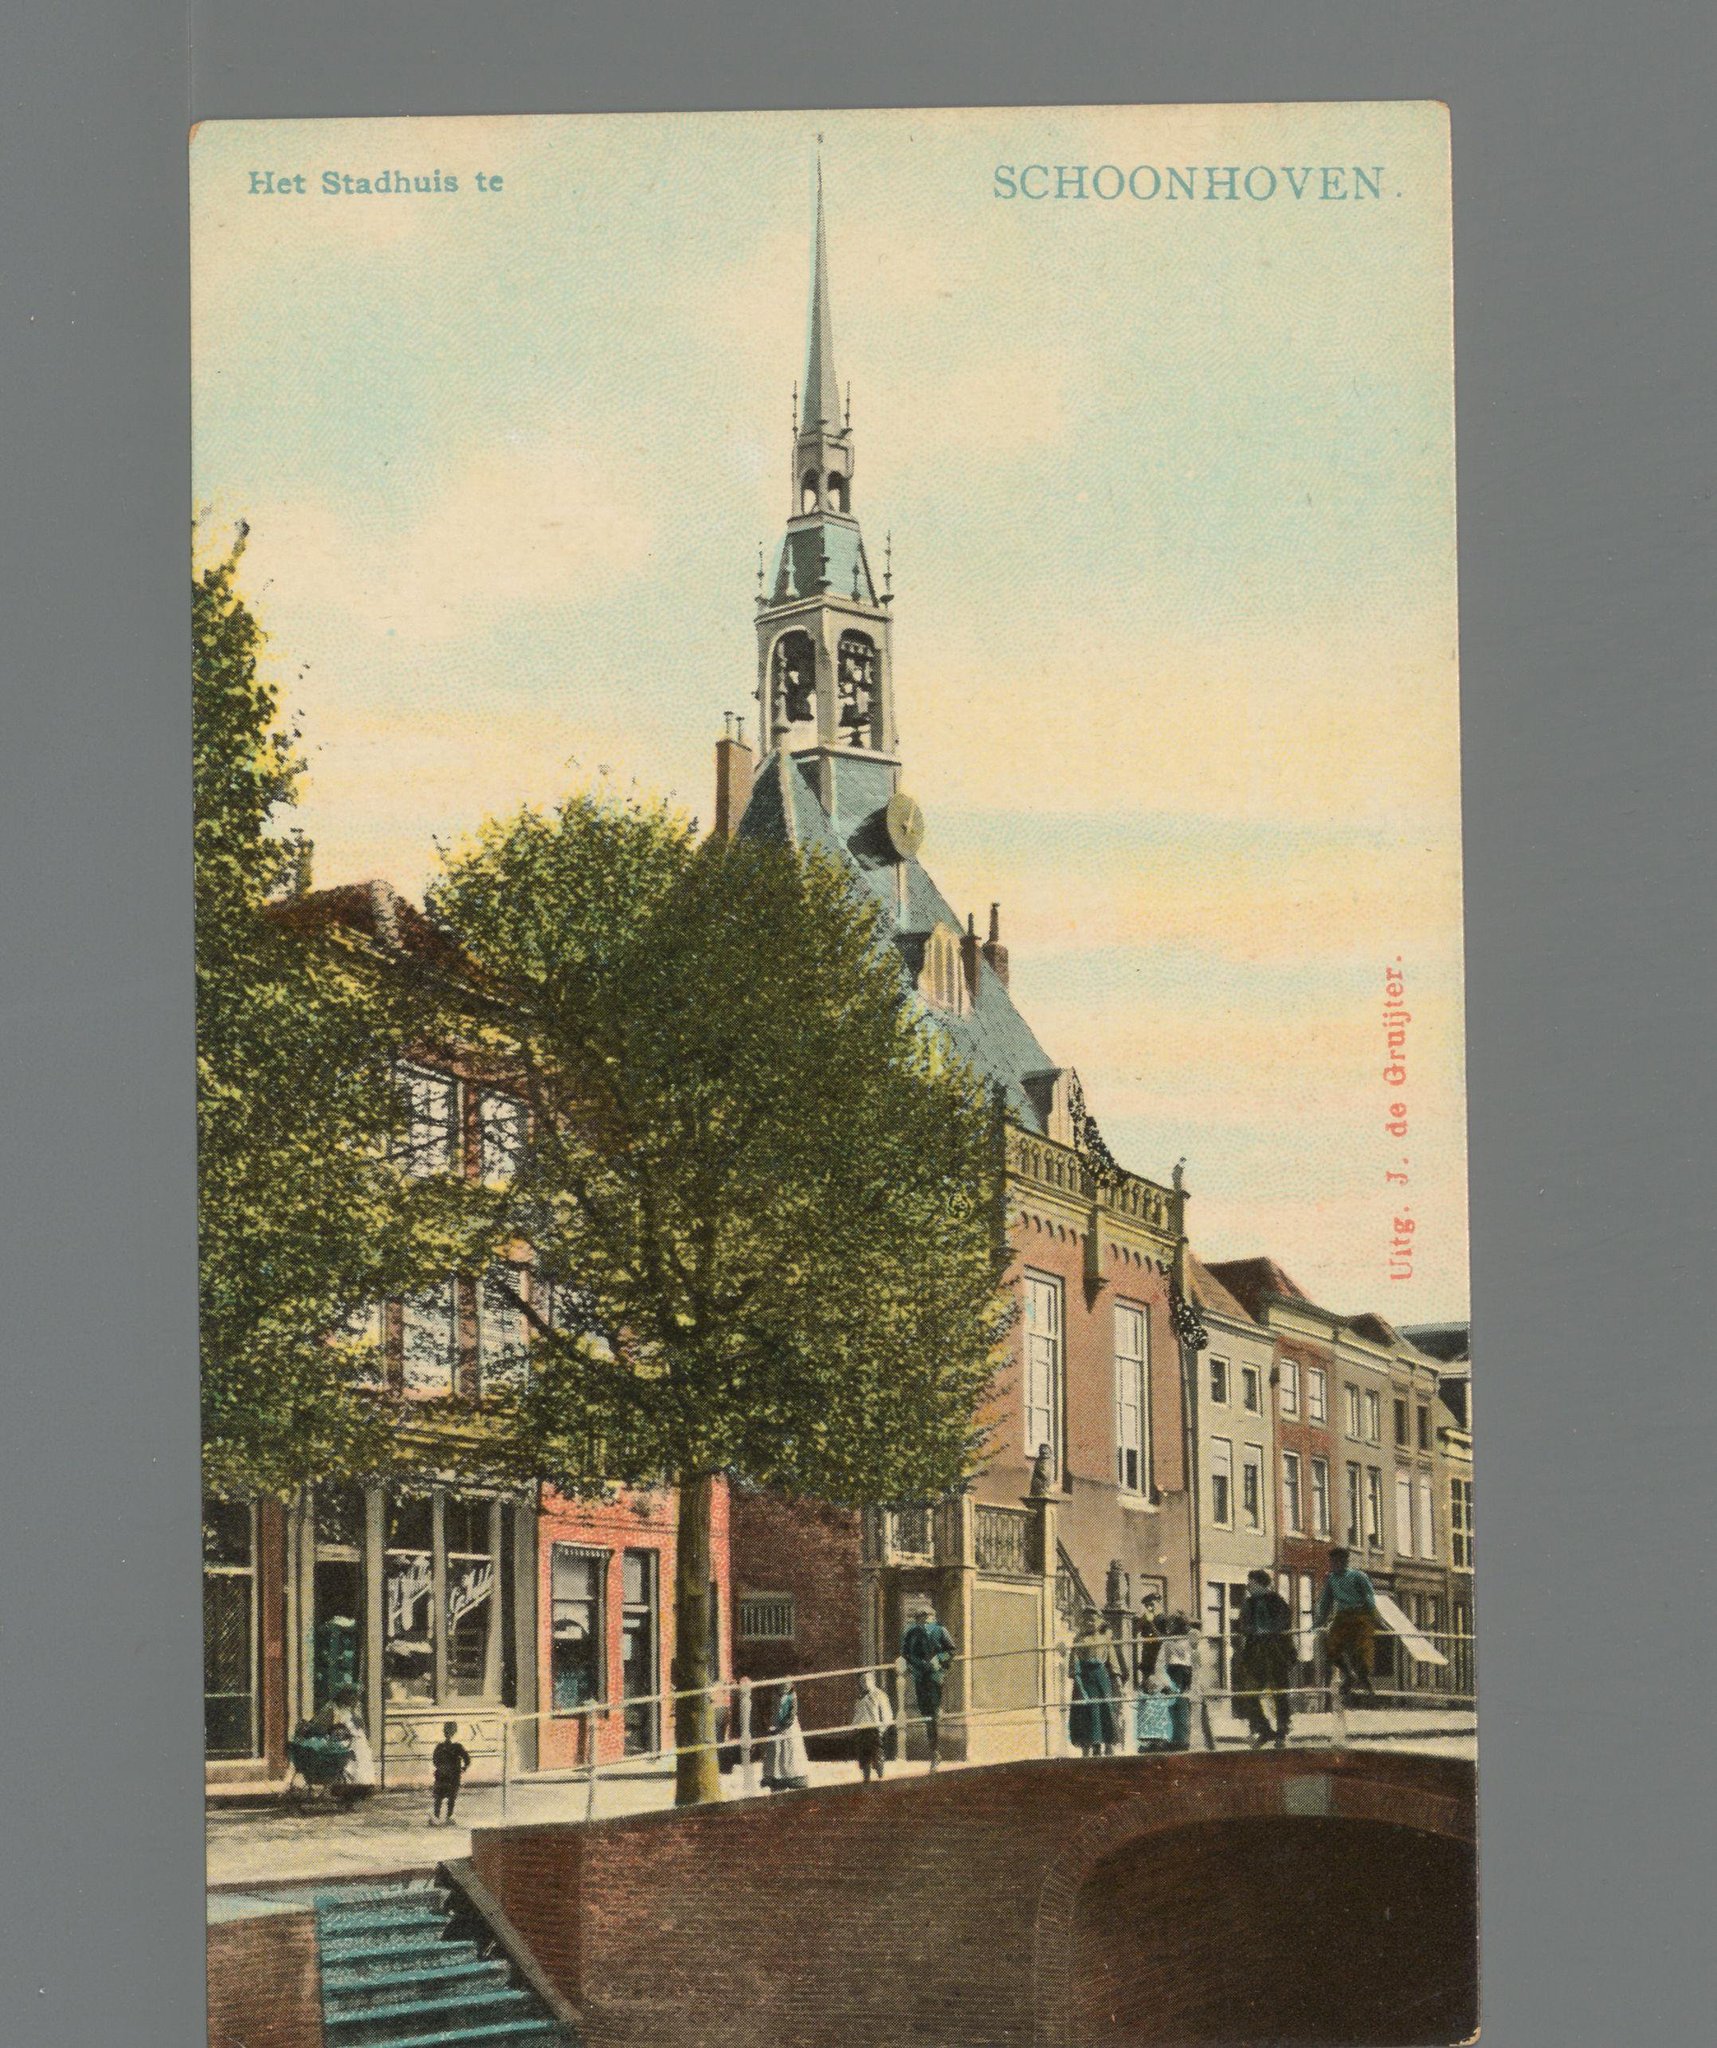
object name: ansichtkaart, prentbriefkaart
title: Het Stadhuis te Schoonhoven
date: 1905-1919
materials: cardboard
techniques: lithograph, writing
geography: schoonhoven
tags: townhall